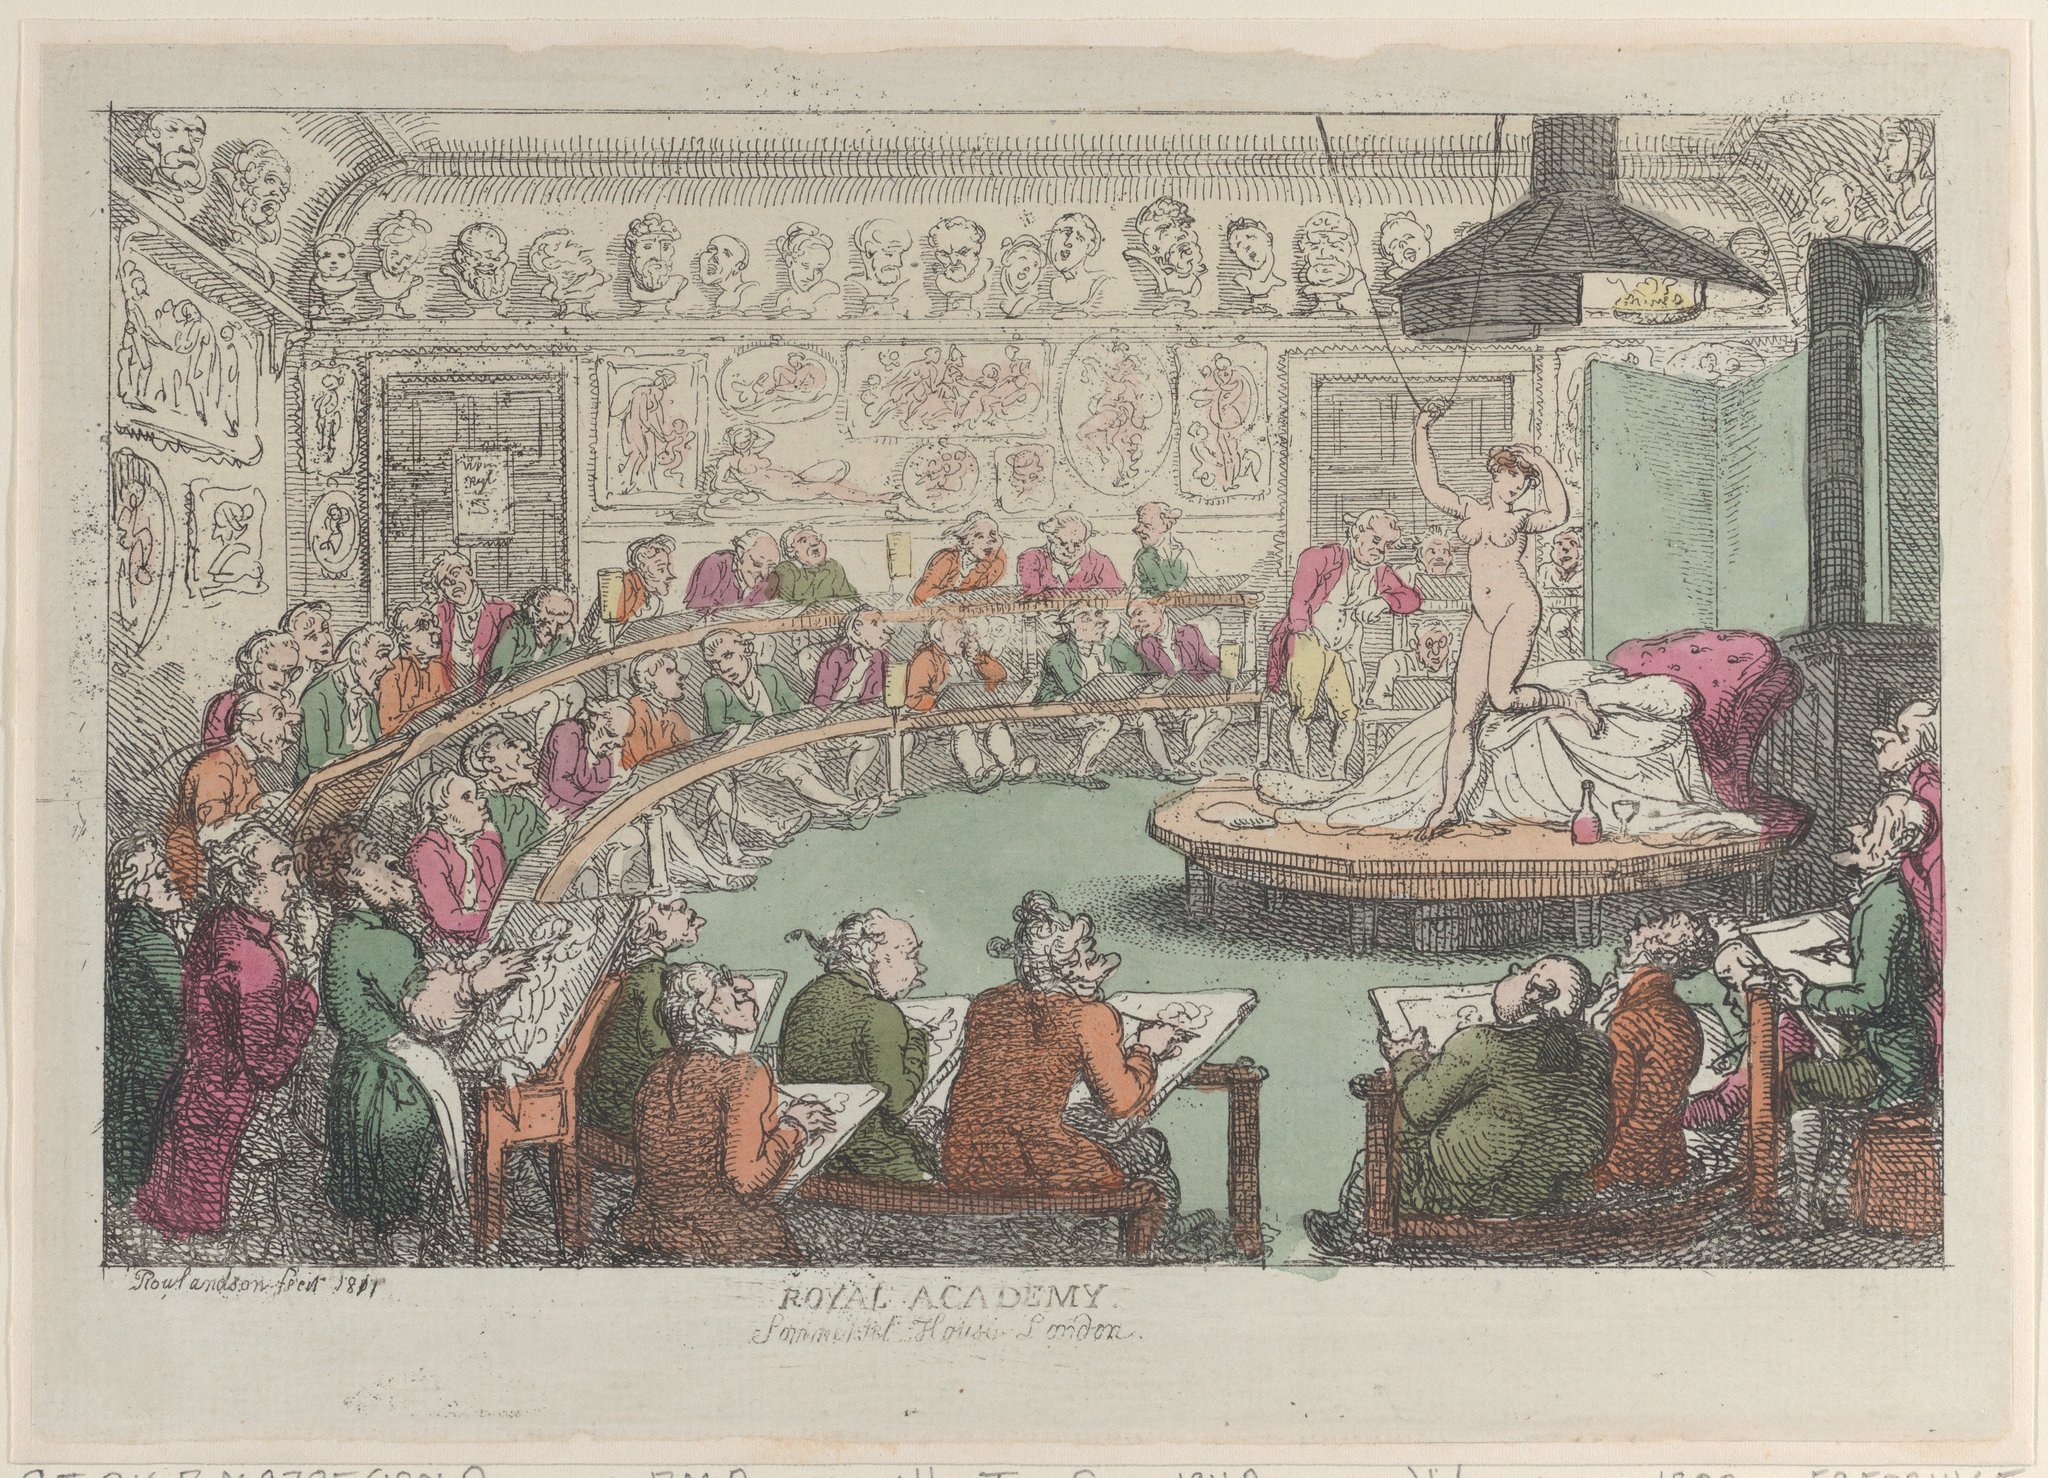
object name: print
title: Royal Academy, Somerset House, London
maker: thomas rowlandson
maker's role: artist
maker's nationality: british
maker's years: 1757-1827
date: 1801-1811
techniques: etching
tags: drawing,satire,men,female nudes